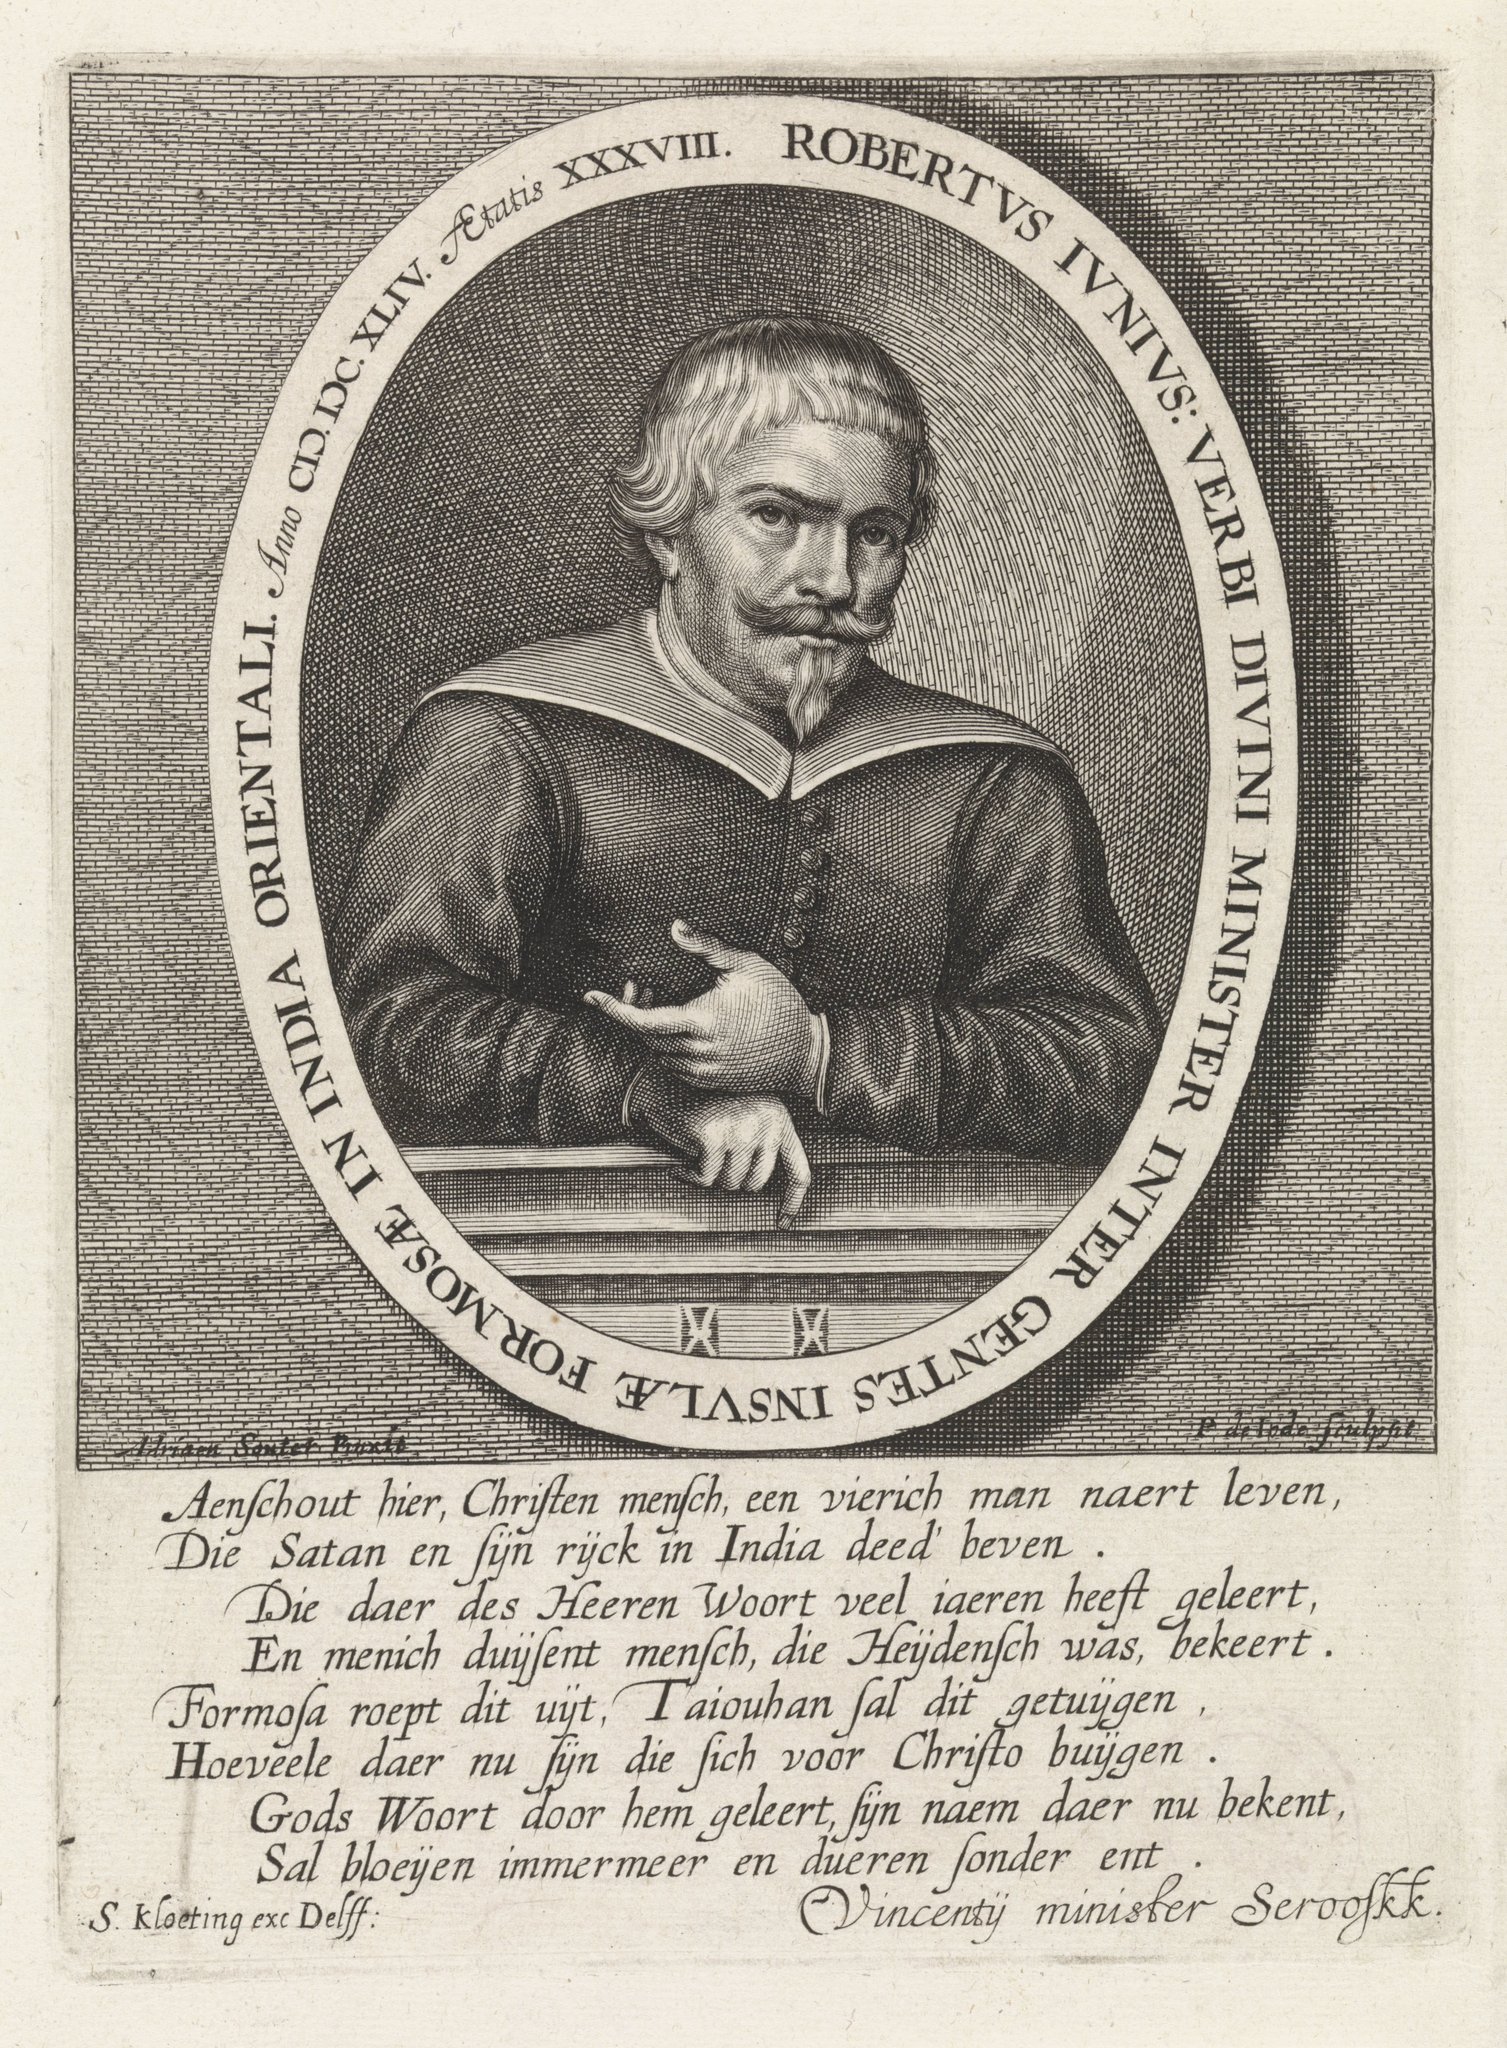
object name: print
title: Portret van Robert Junius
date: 1628-1670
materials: paper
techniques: engraving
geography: antwerp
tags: rotterdam, amsterdam, historical persons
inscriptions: collector's mark: Lugt 240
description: Busteportret van Robert Junius, op 38-jarige leeftijd. Het portret is gevat in een ovale omlijsting met een randschrift in het Latijn. In de marge een achtregelig gedicht in het Nederlands.